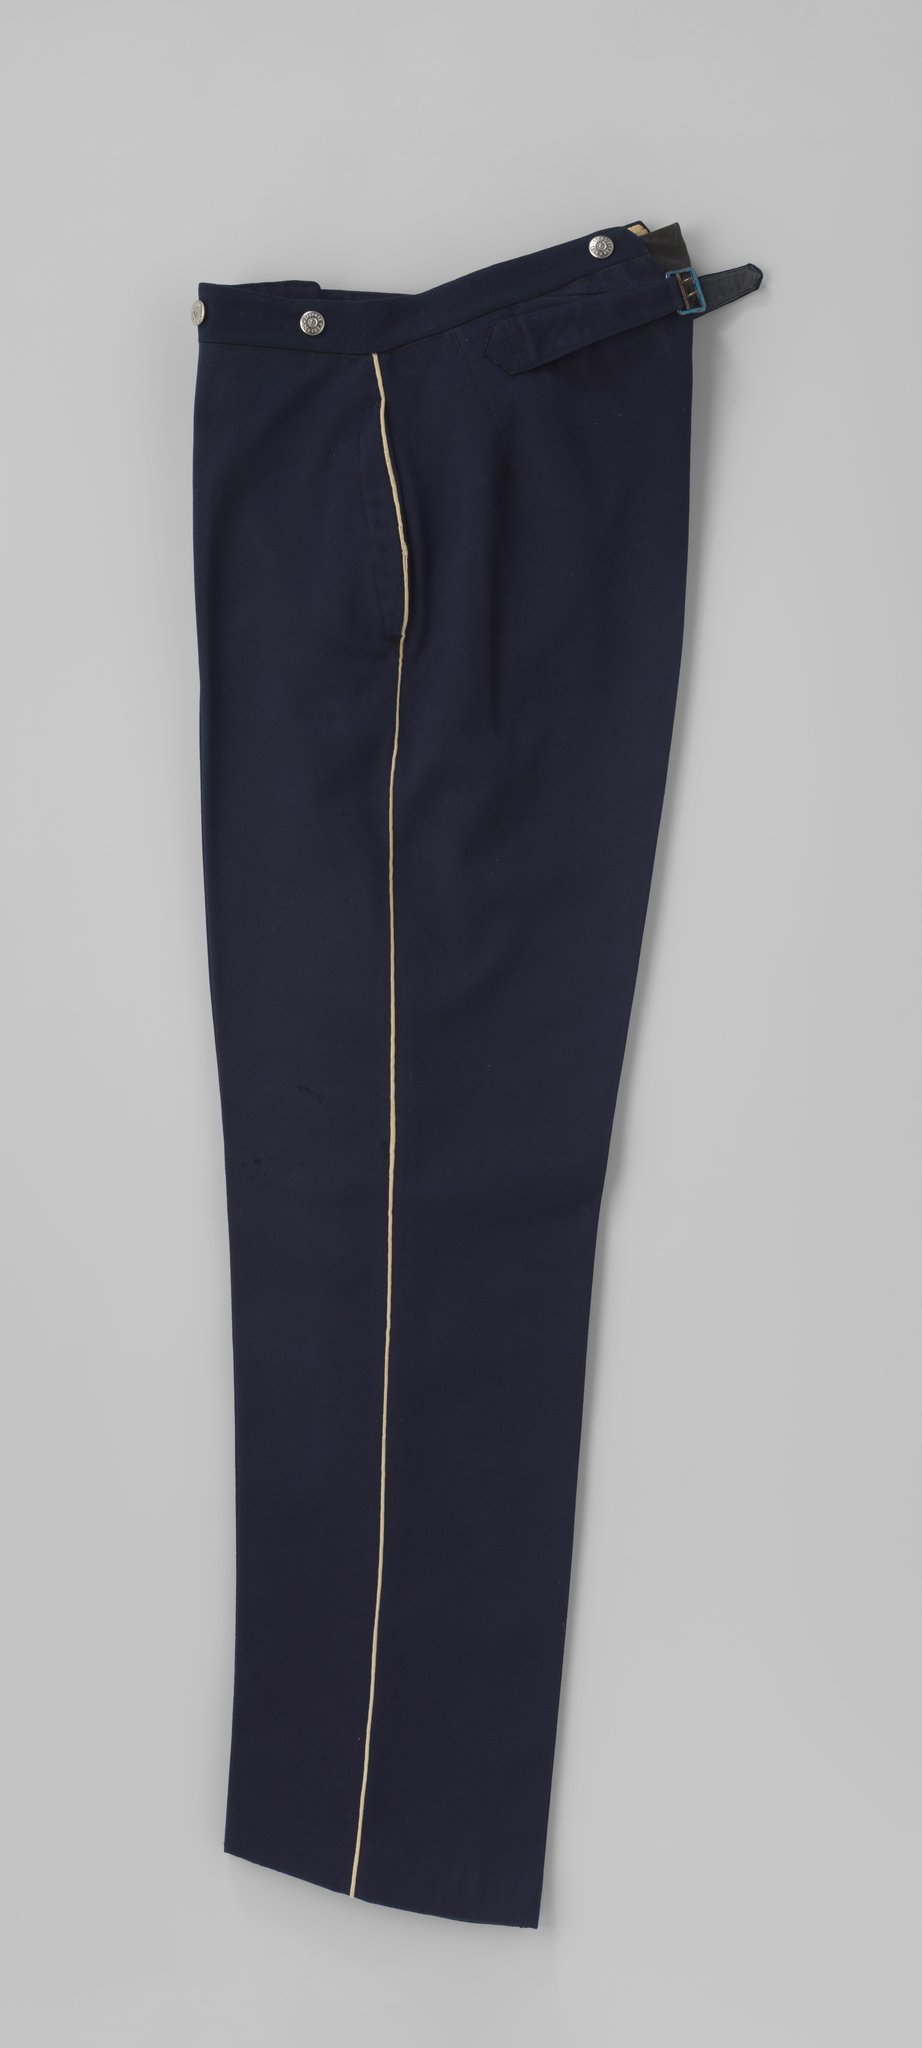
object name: menswear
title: Lange rechte broek met metalen knopen (gemerkt: solide neuheit) van wit gebiesd blauw laken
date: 1913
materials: textile, cotton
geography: the hague